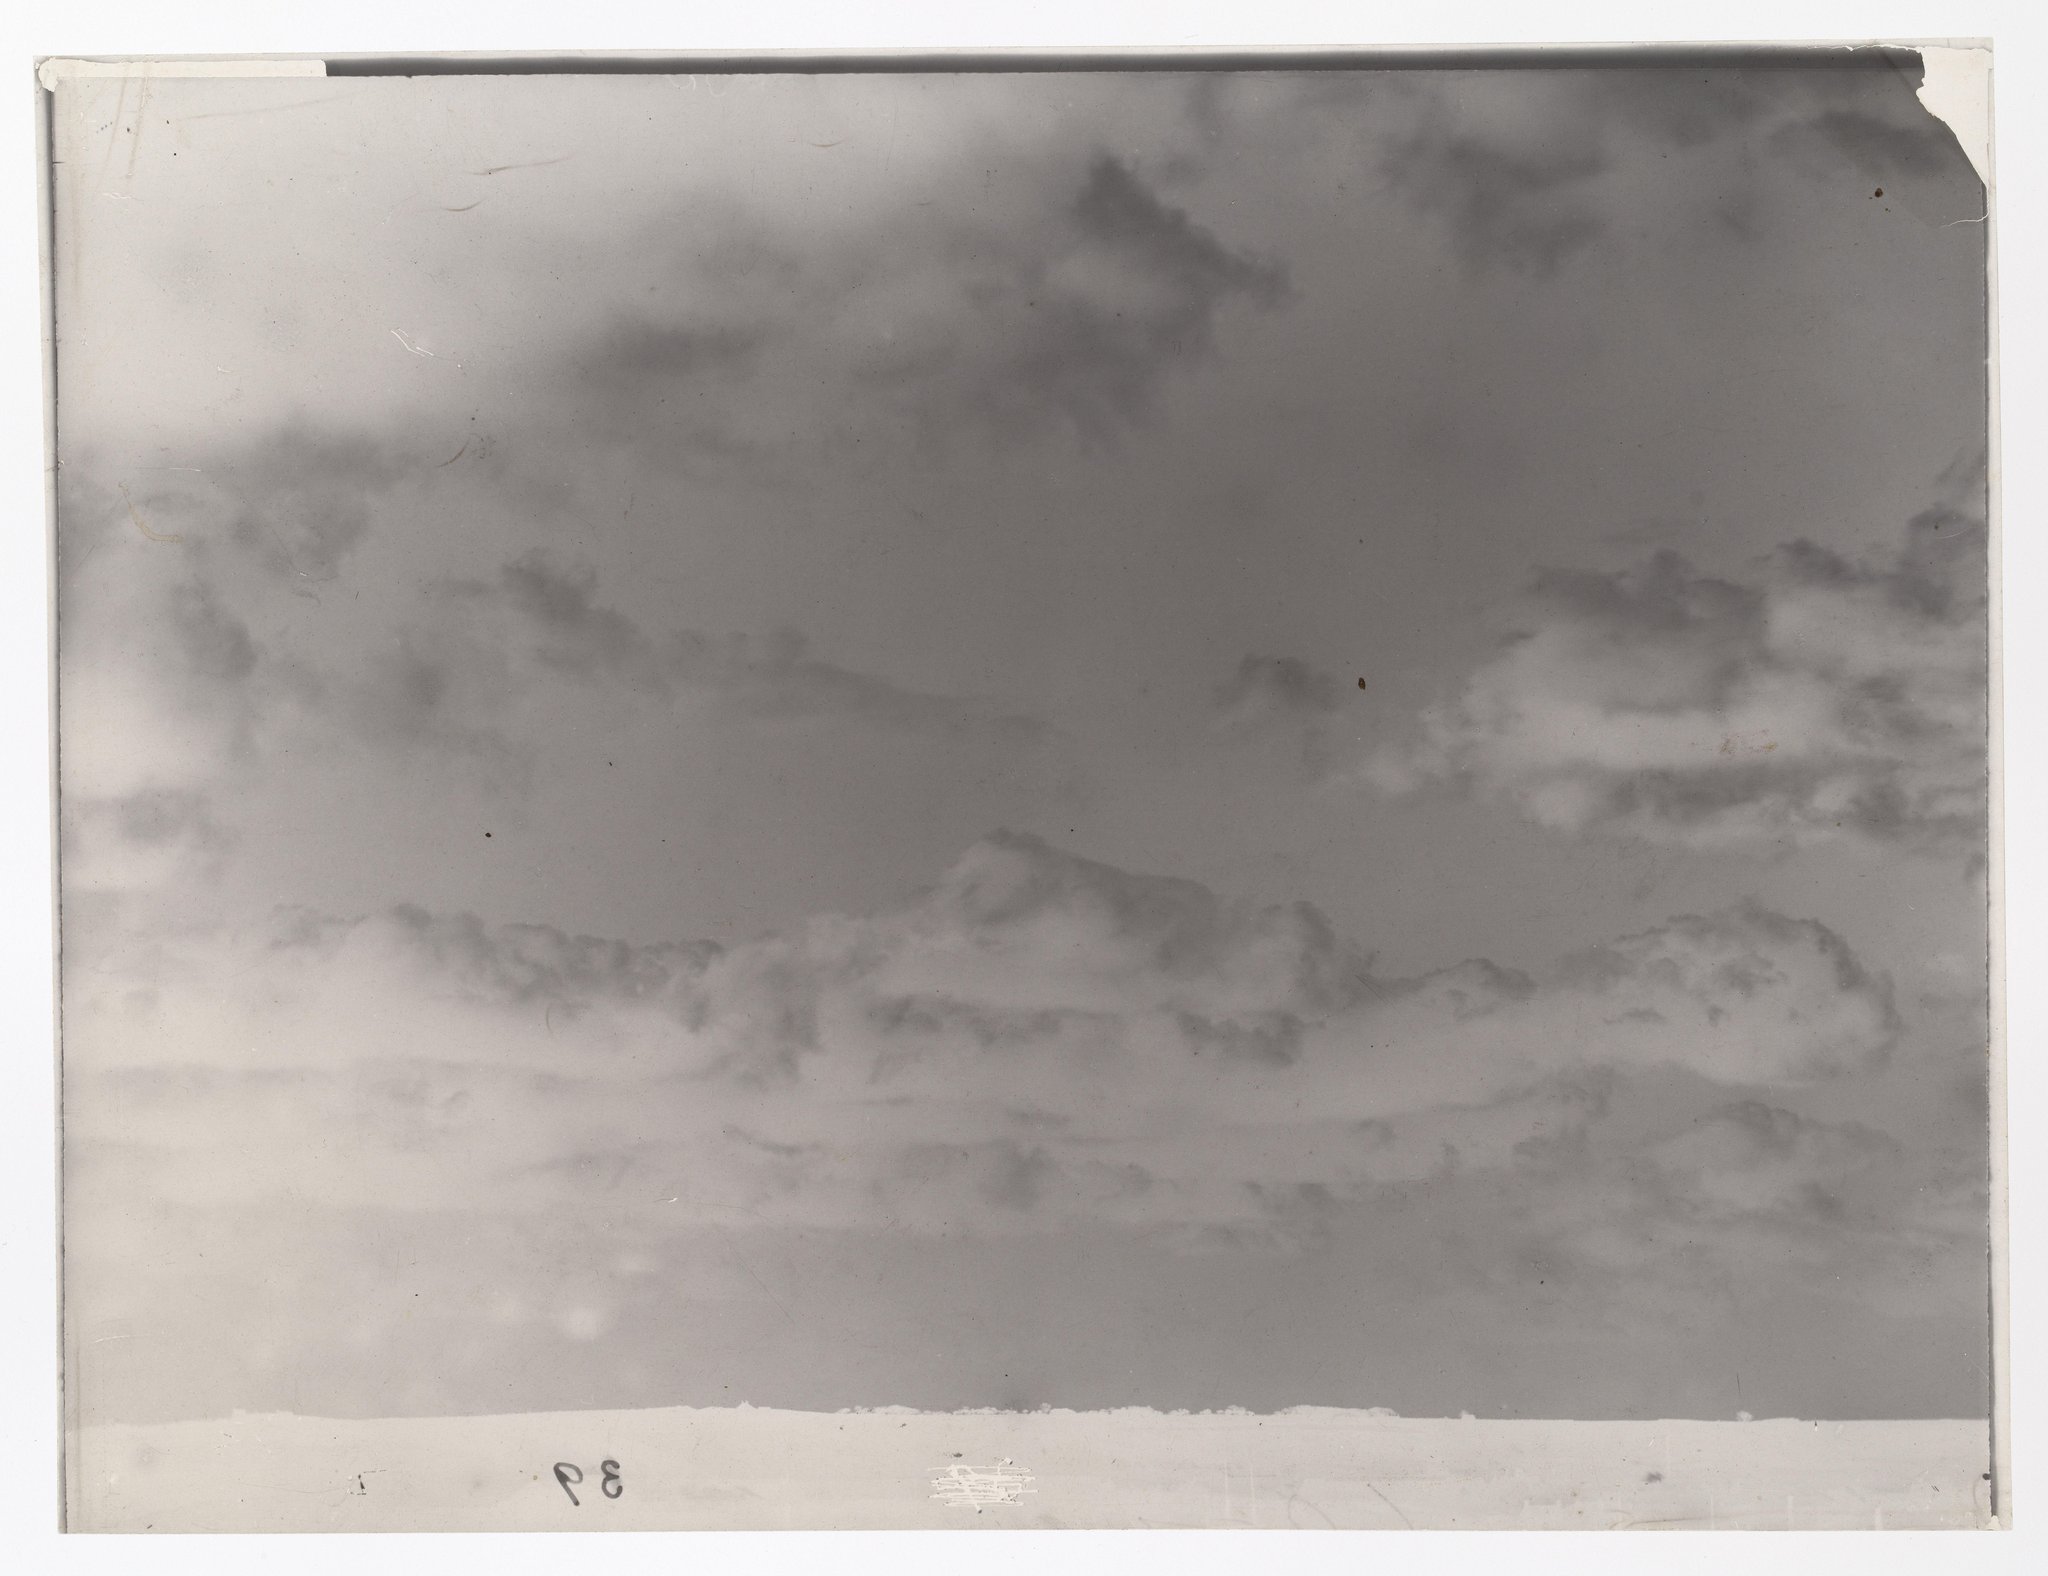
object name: filmnegatief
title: Wolkenlucht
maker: Anonymous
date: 1900-1950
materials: plastic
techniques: gelatin silver negative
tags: clouds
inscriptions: number: ‘39’